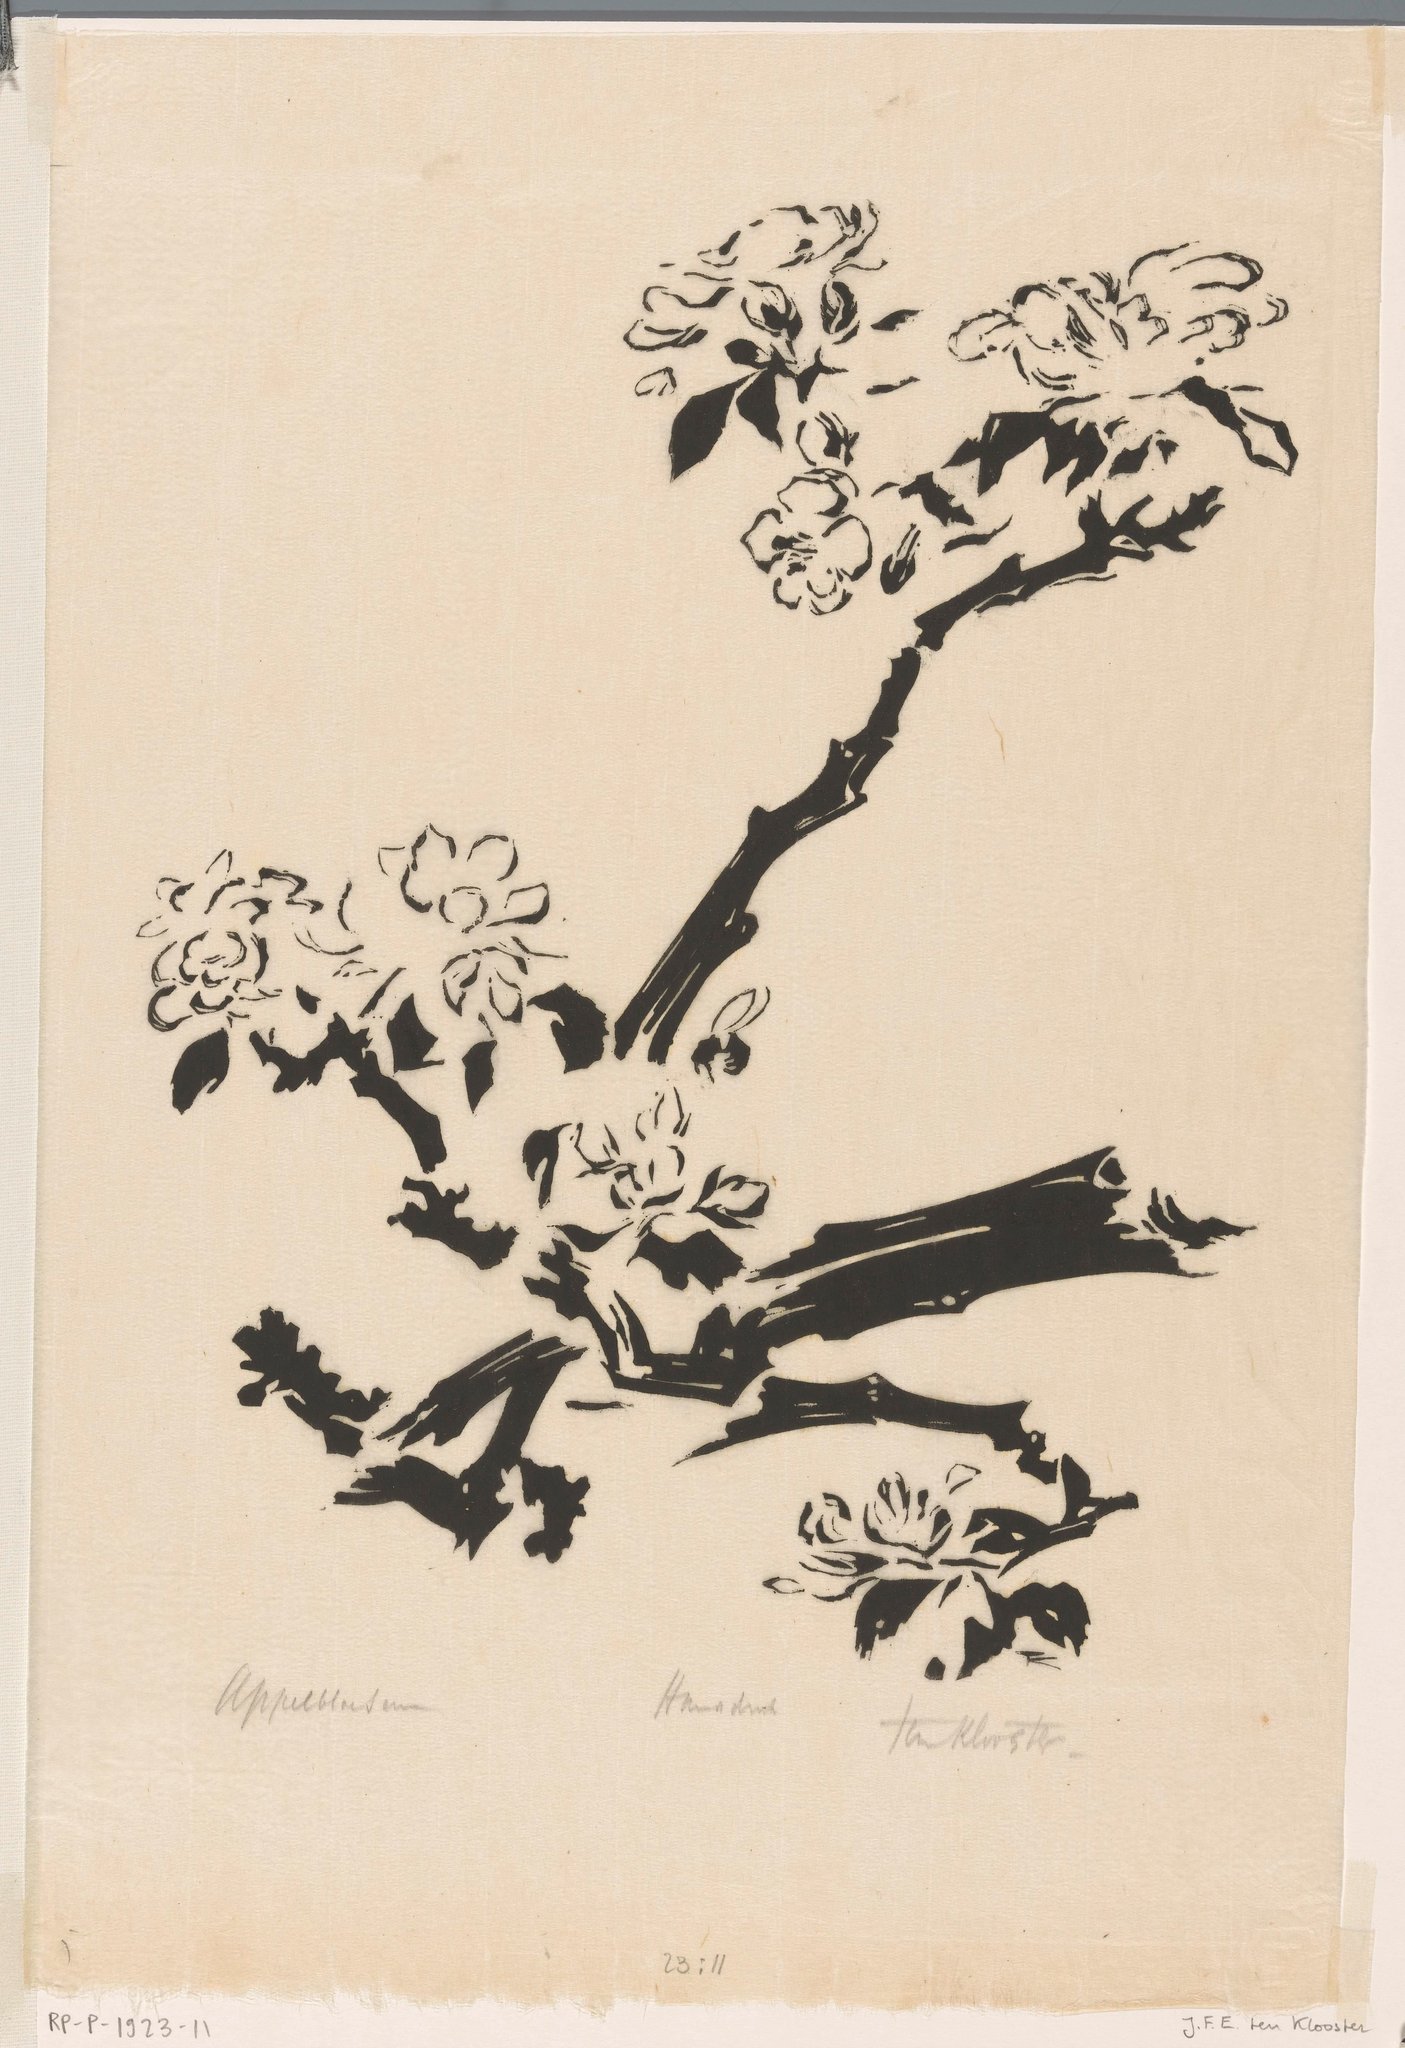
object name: print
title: Appelbloesem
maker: johannes frederik engelbert ten klooster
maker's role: draughtsman, print maker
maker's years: 1873-1940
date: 1922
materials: paper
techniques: woodcut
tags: fruits: apple (flowers, blossom, blossoming)